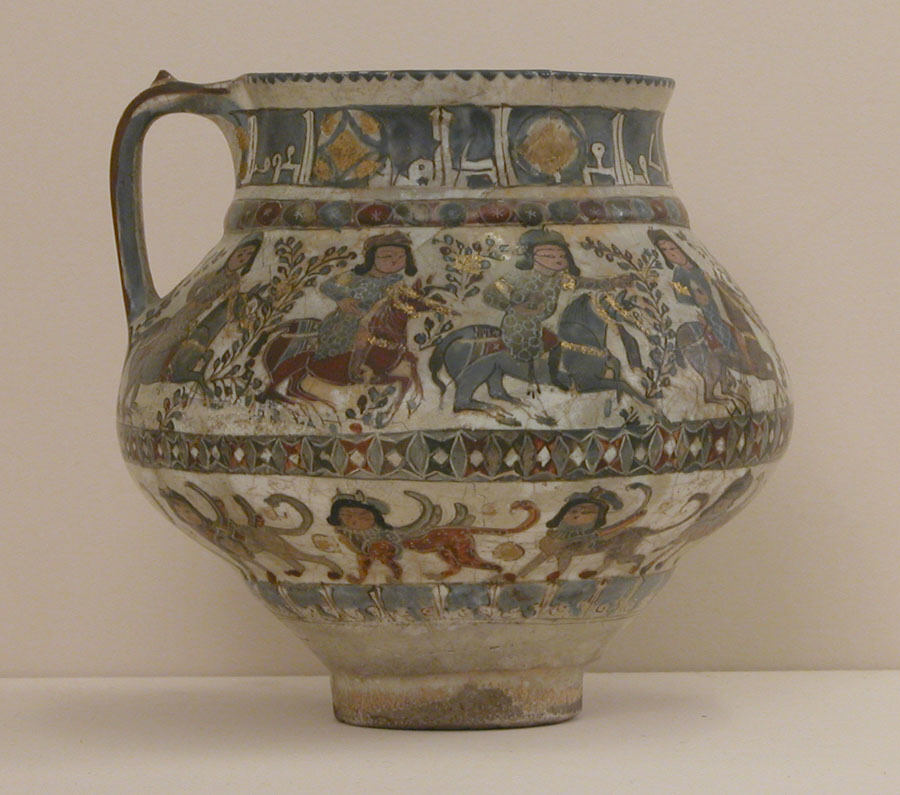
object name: ewer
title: Ewer with Horsemen and Sphinxes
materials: glaze, stonepaste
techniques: gilding, overglaze, painting, polychrome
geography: iran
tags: sphinx,horses